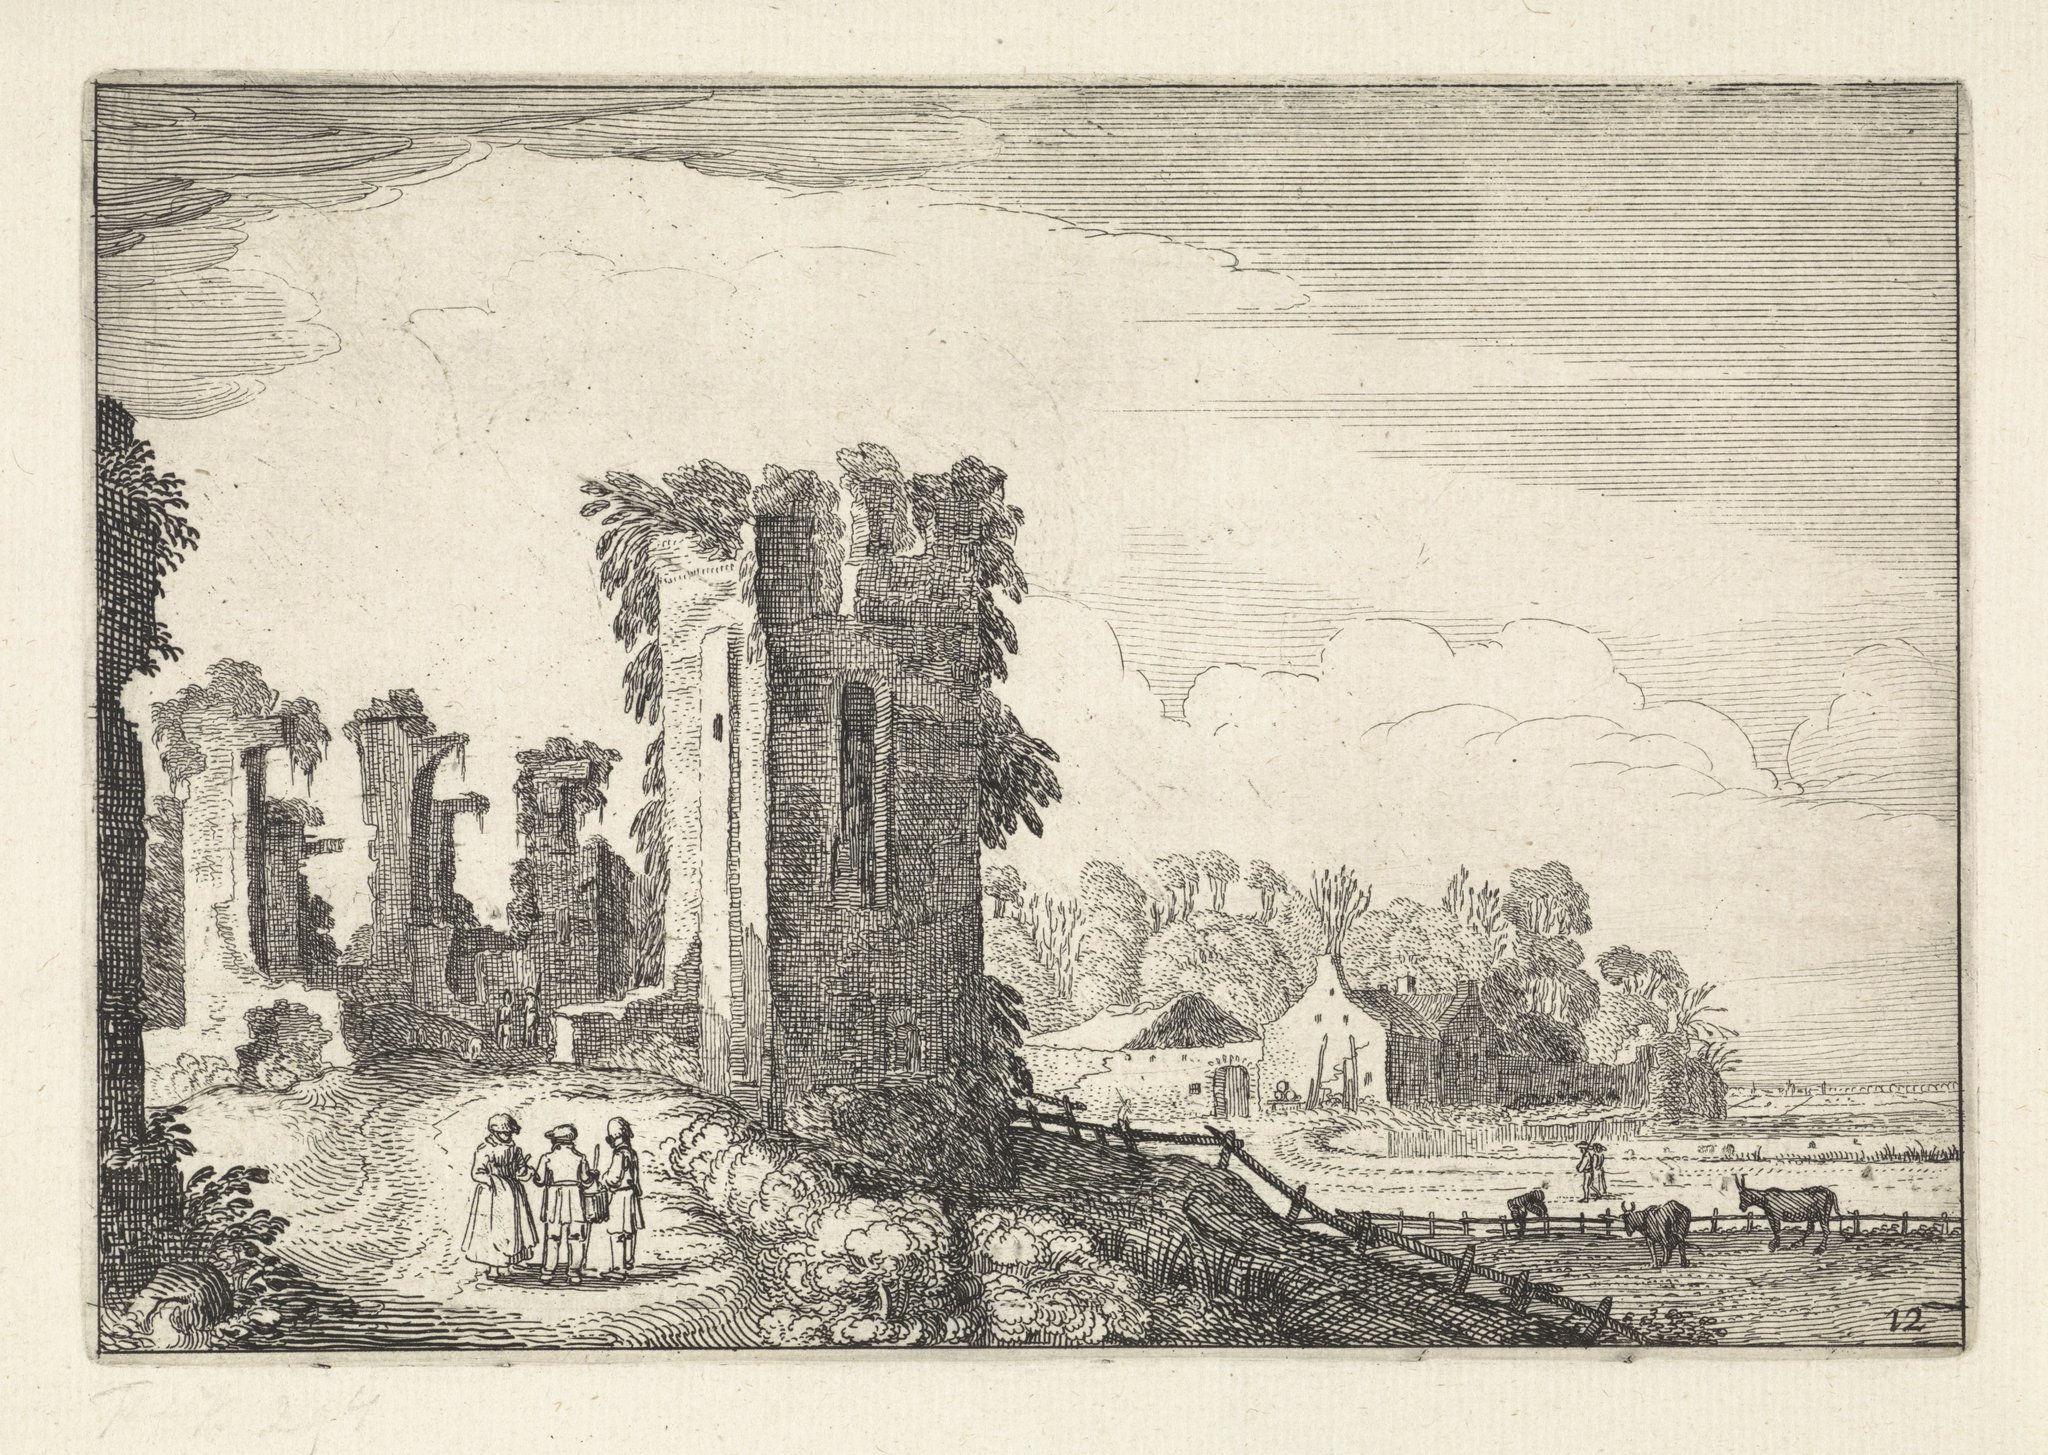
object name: print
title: Figuren bij het Huis ter Kleef bij Haarlem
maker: jan van de velde (ii)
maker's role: draughtsman, painter, print maker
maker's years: 1593-1641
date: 1616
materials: paper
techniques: etching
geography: northern netherlands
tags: landscape with ruins, ruin of a dwelling, house, castle, etc.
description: Figuren bij het Huis ter Kleef bij Haarlem. Op de achtergrond een boerderij. Twaalfde prent van deel twee van een serie van in totaal zestig prenten met landschappen, verdeeld over vijf delen van elk twaalf prenten.